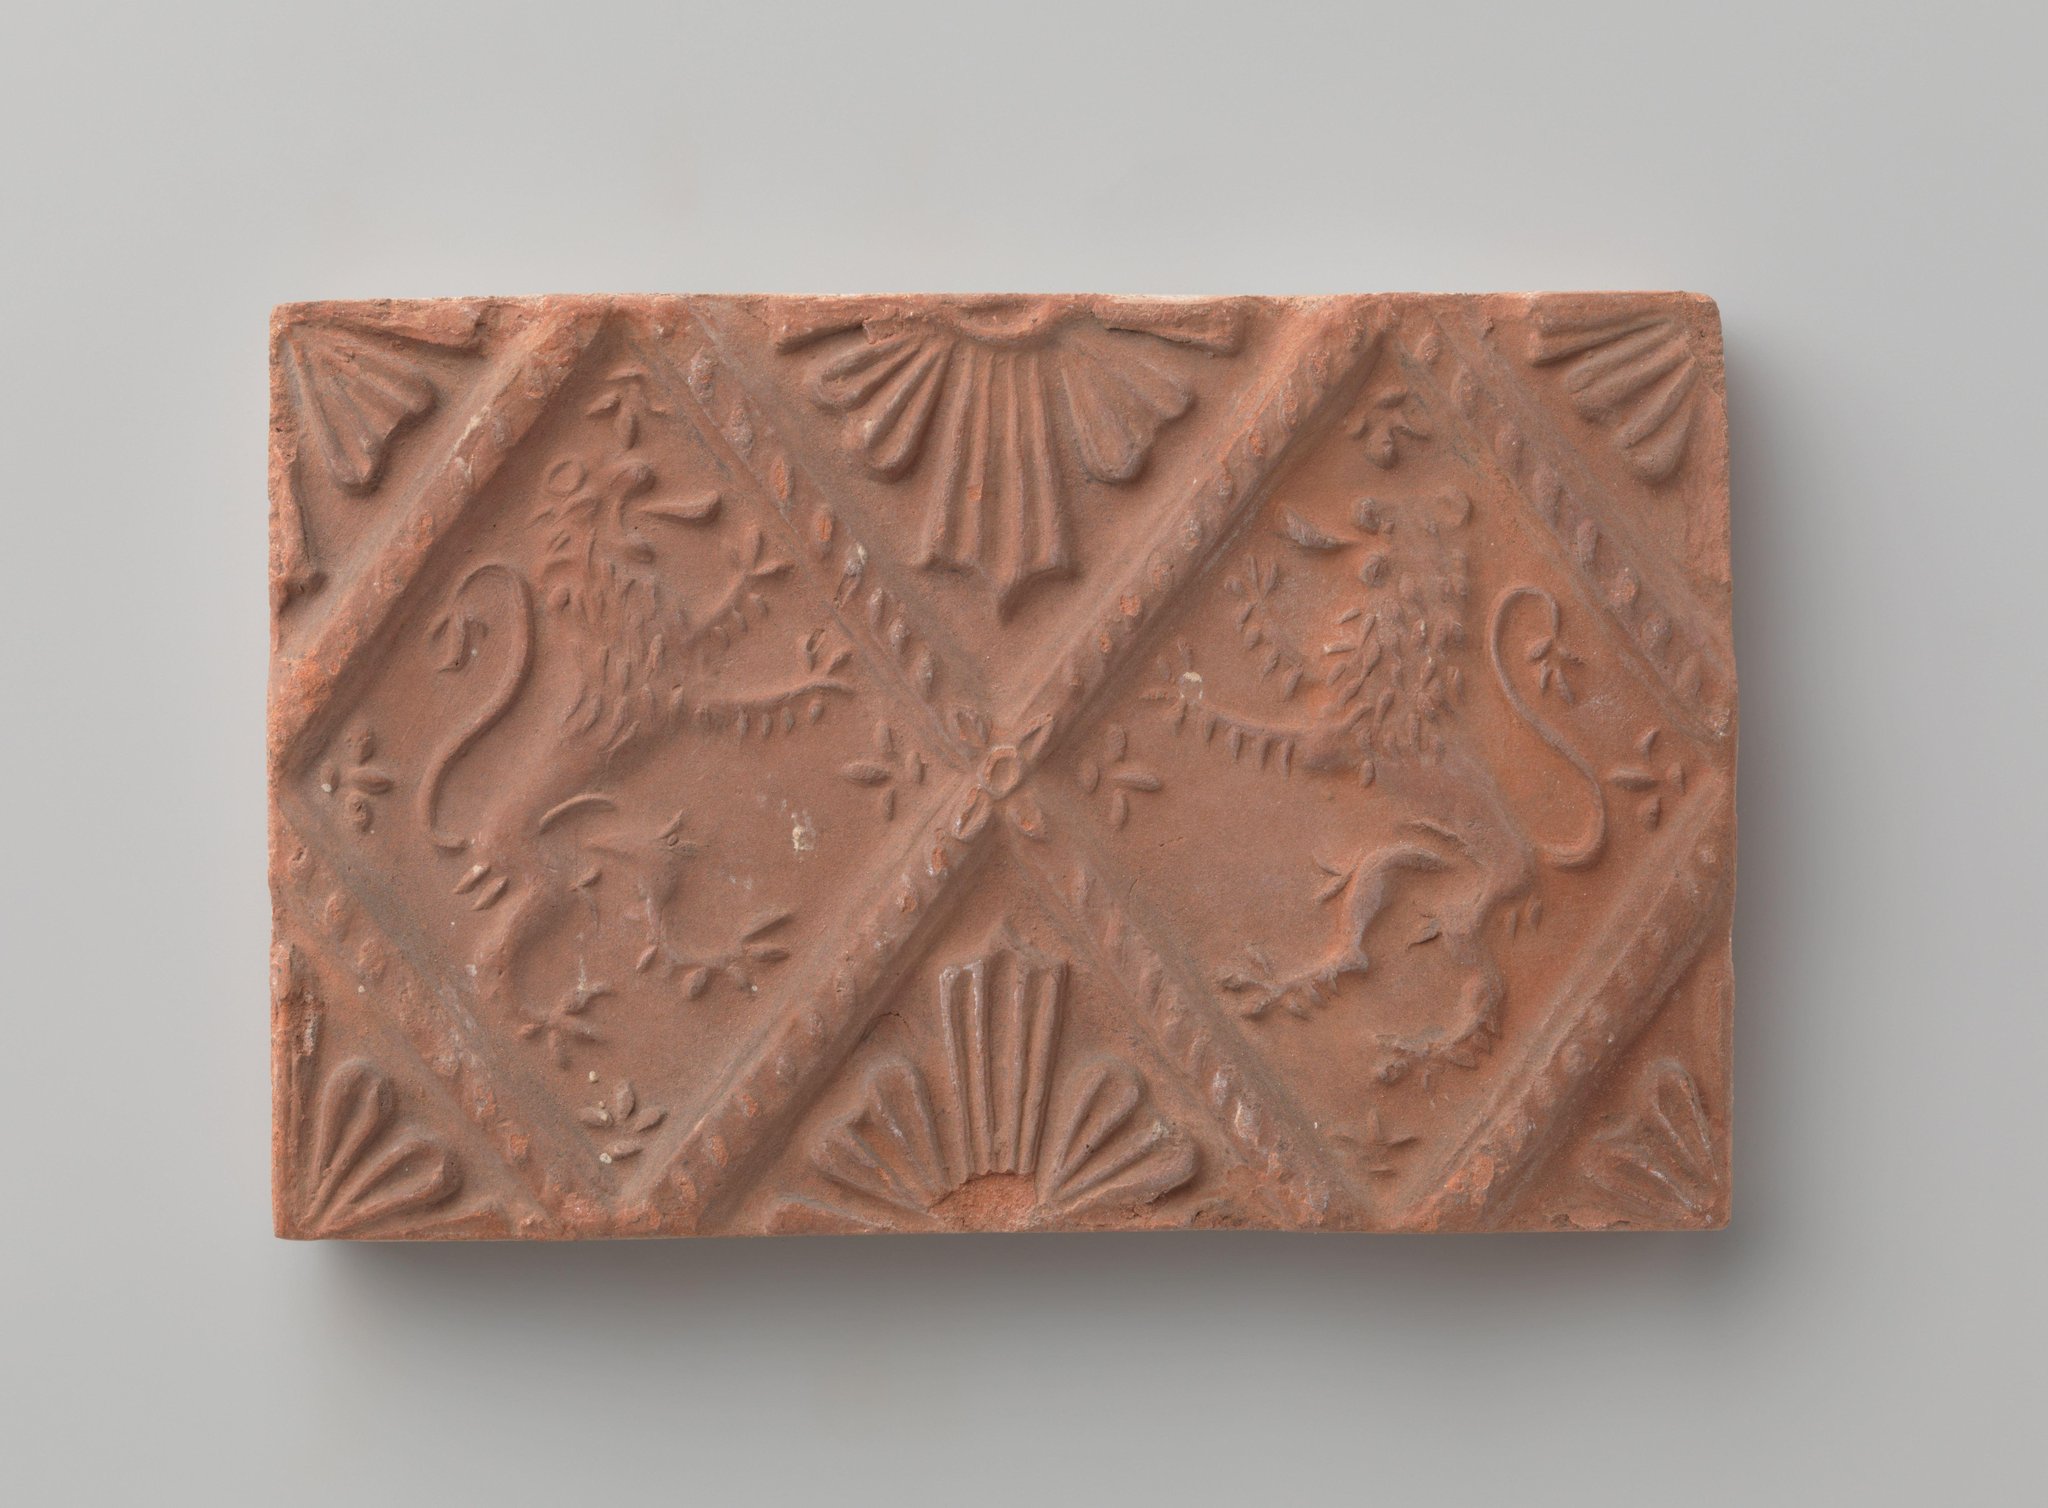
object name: hearthstone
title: Haardsteen met voorstelling van twee klimmende leeuwen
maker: Anonymous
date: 1875-1900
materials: earthenware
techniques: printing, firing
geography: netherlands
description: Haardsteen met voorstelling van twee klimmende leeuwen, geplaatst in geprofileerde ruit. De halve ruiten aan de boven- en onderkant zijn opgevuld met stermotief.